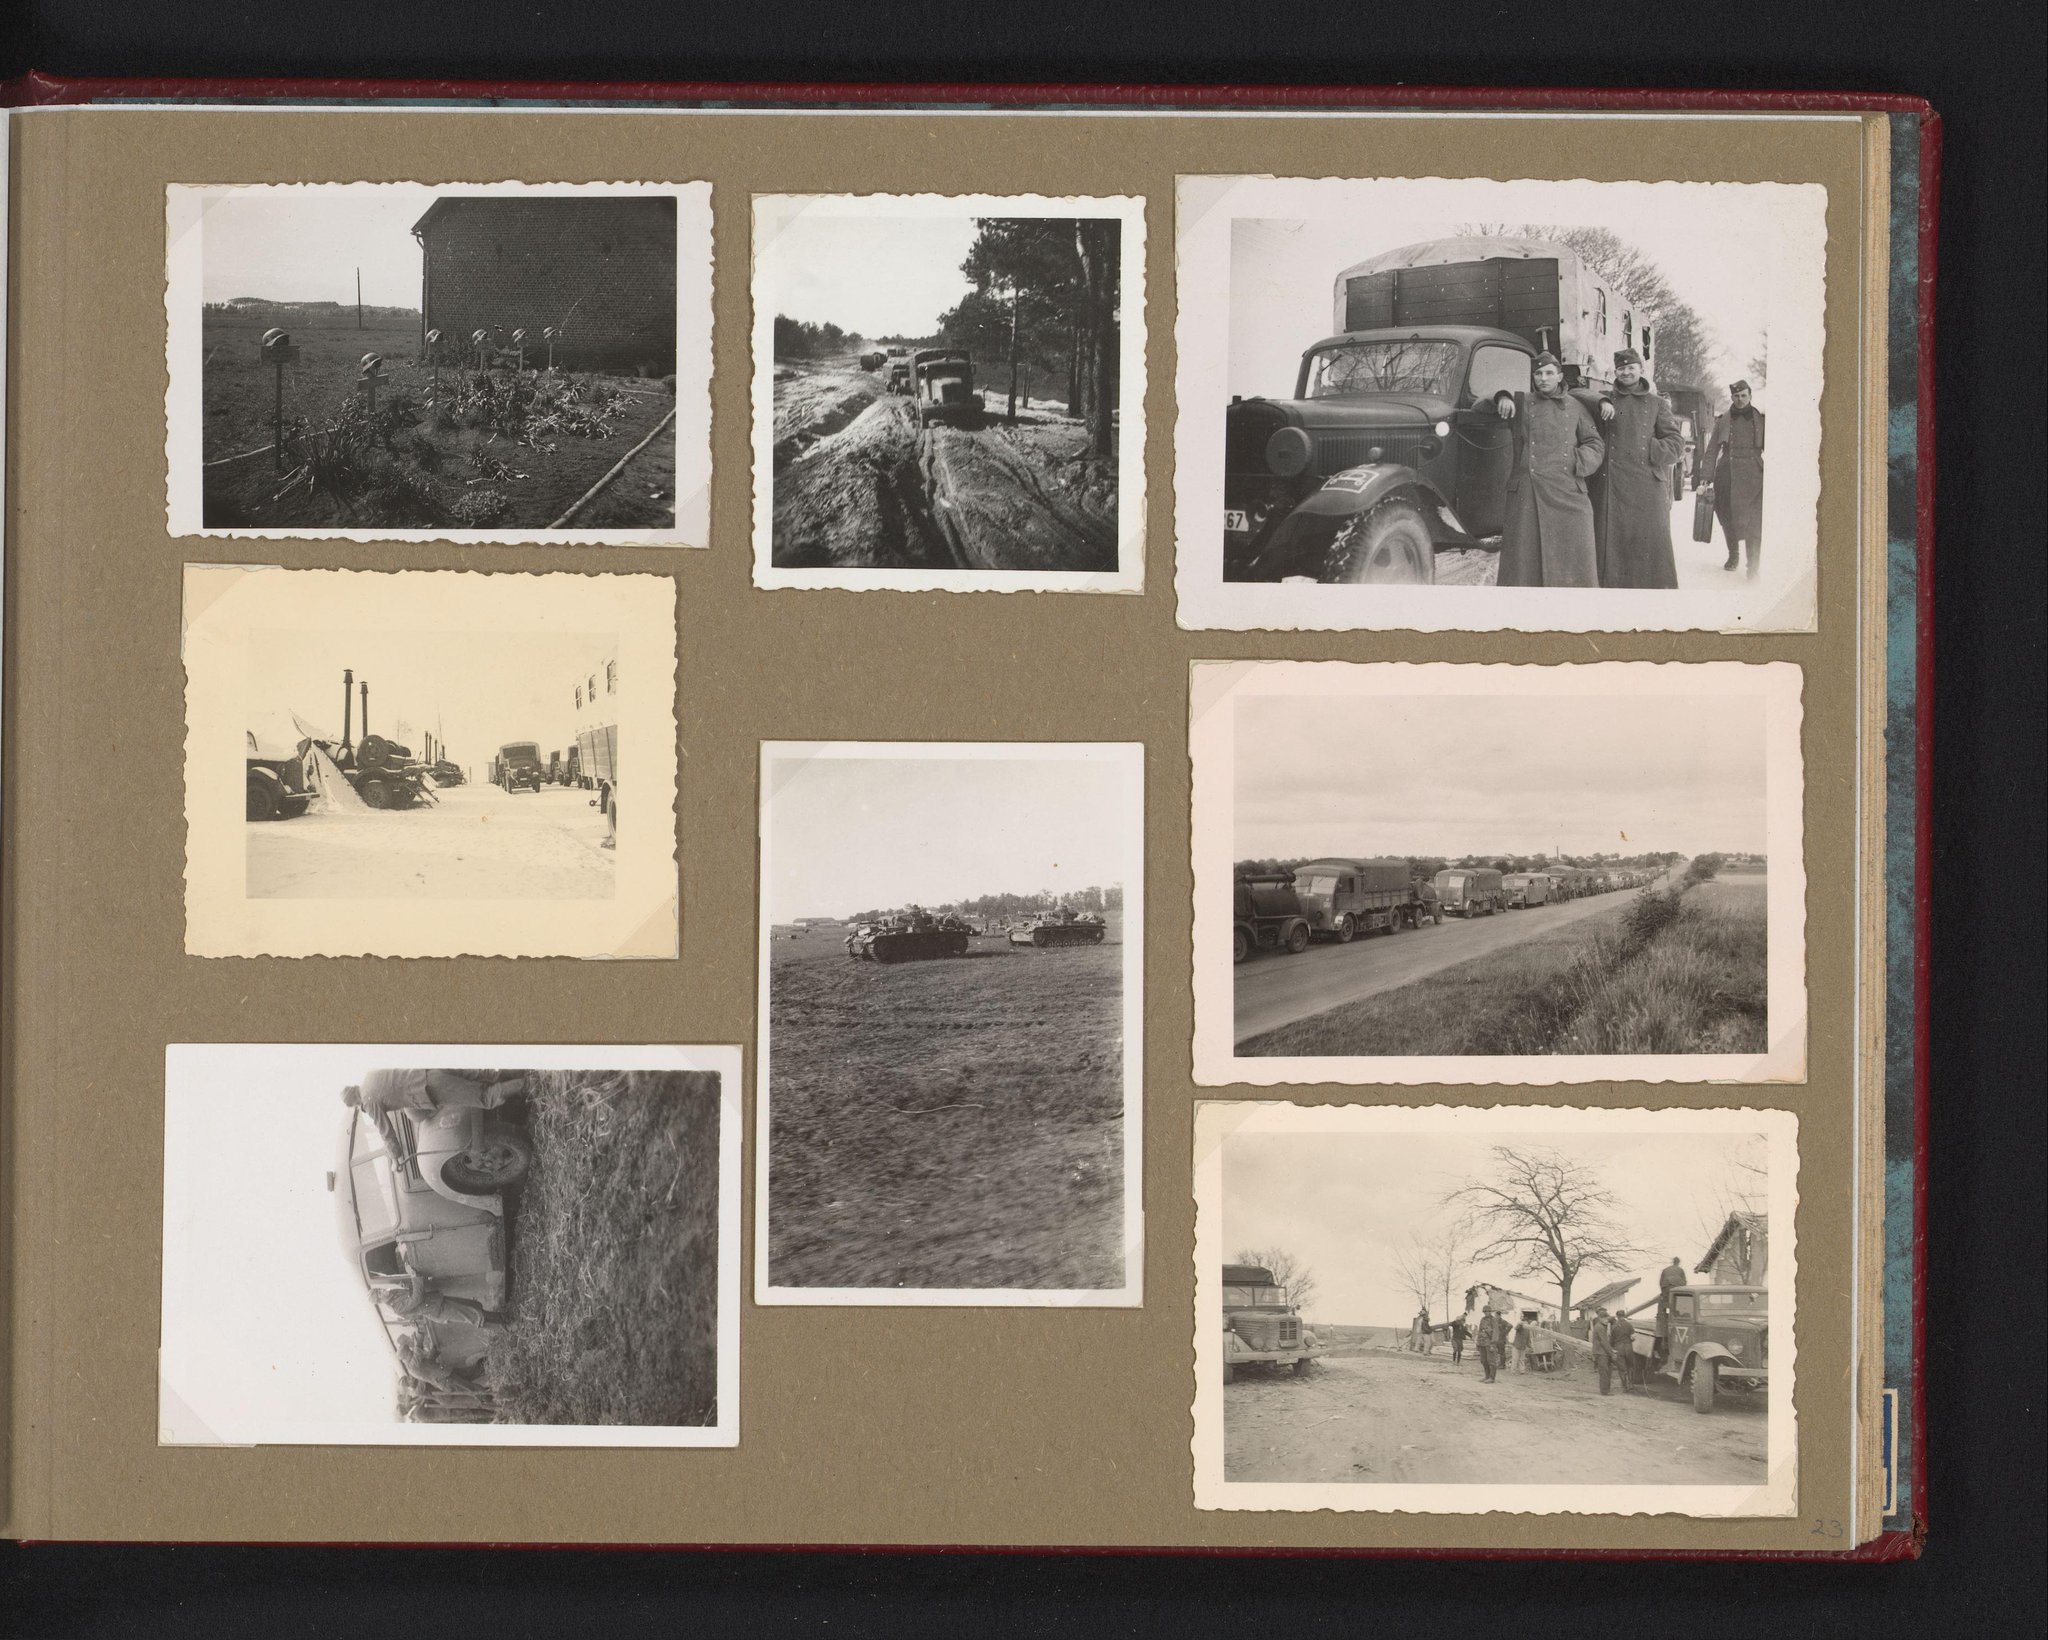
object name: album leaf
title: Wehrmacht soldaten in Hongarije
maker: Anonymous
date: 1940-1943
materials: paper, photographic support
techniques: gelatin silver print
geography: hungary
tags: the company, the unit, the troop ~ military service, modern forms of military vehicles (tank), occupation ~ war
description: Albumblad met acht foto's van de Duitse Wehrmacht in Hongarije. Duitse oorlogsgraven, tanks, militair transport van vrachtwagens over slecht begaanbare wegen. Onderdeel van het fotoalbum over soldaten van de Wehrmacht, ca. 1939-1943.